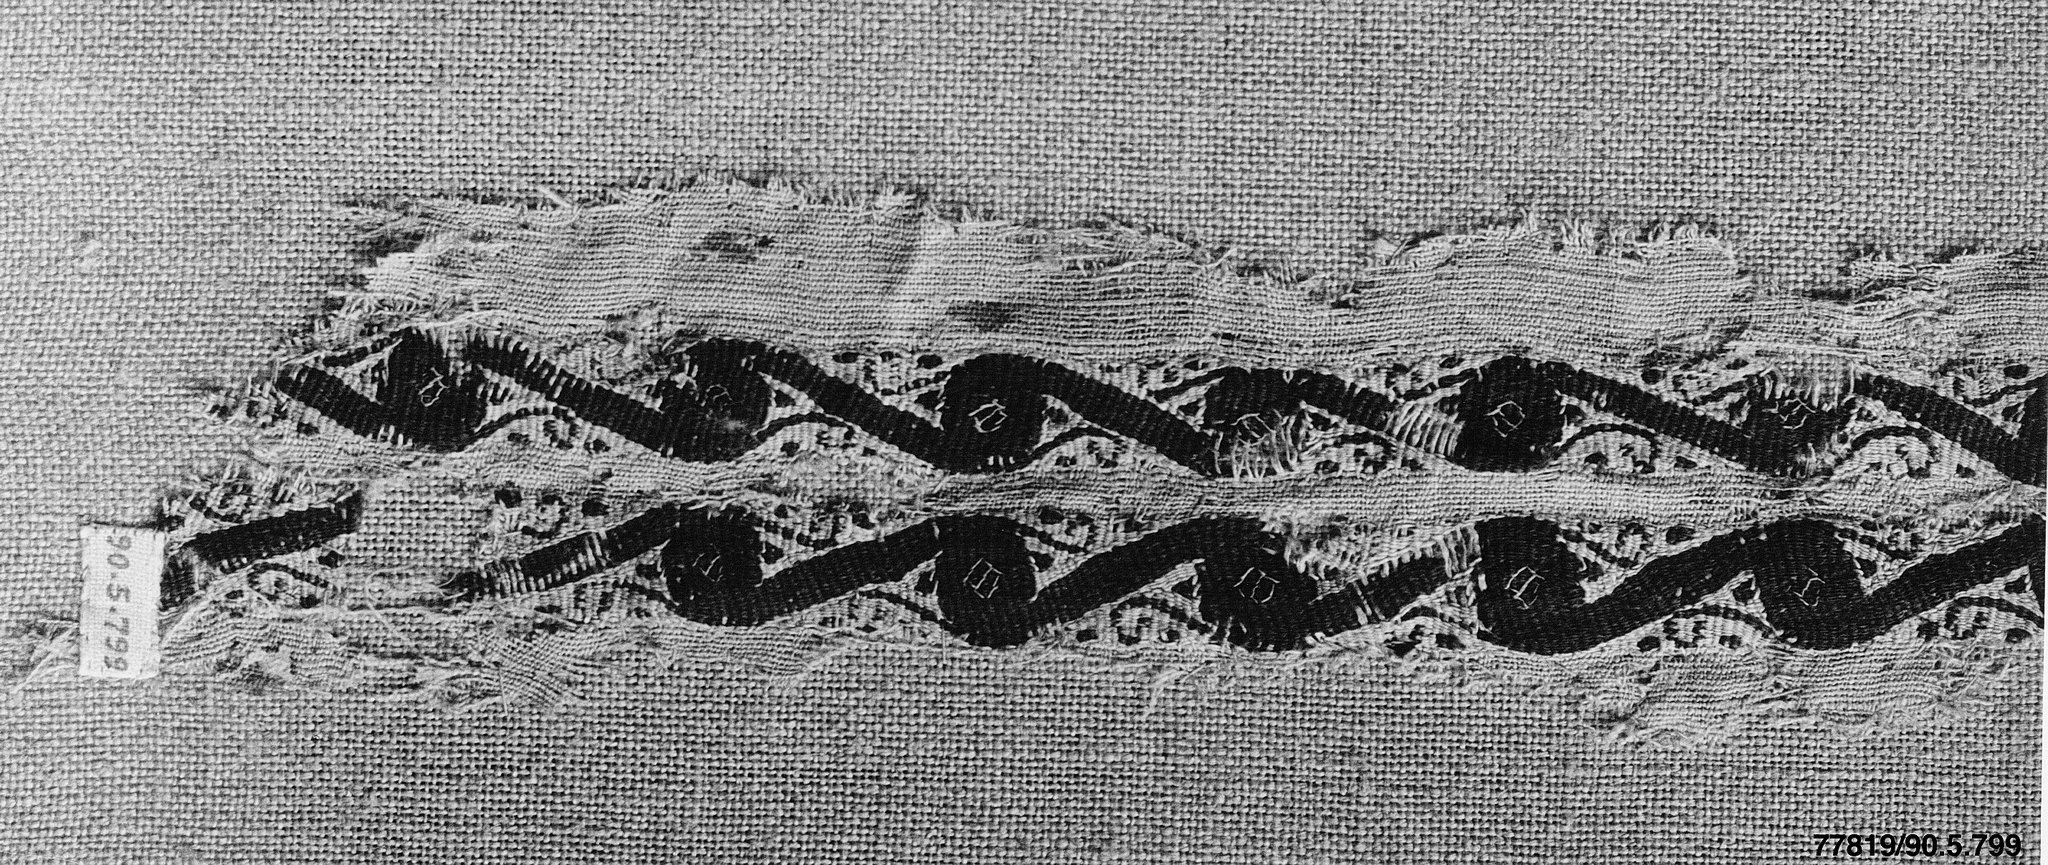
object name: textile fragment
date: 201-400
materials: linen, wool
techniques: weave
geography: egypt